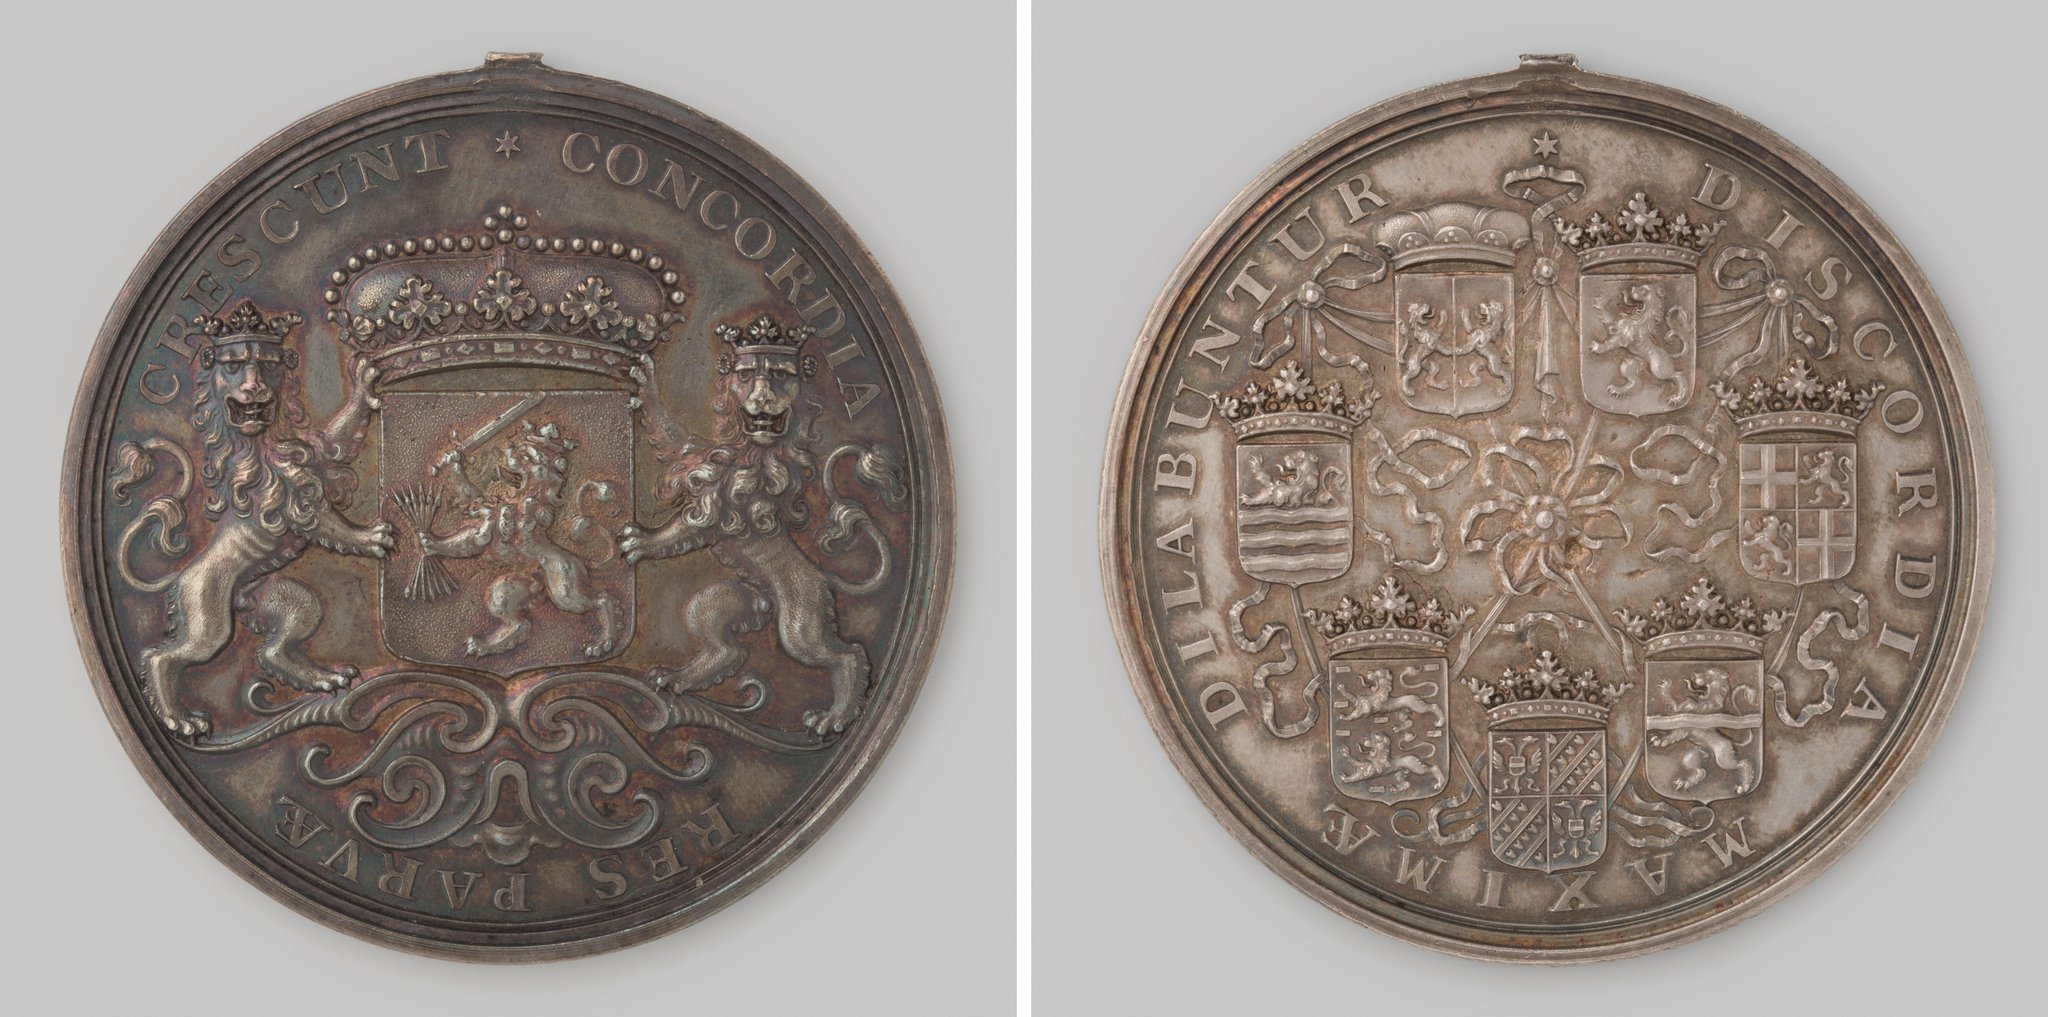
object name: beloningspenning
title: Ambassadeurspenning 1609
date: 1609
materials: silver